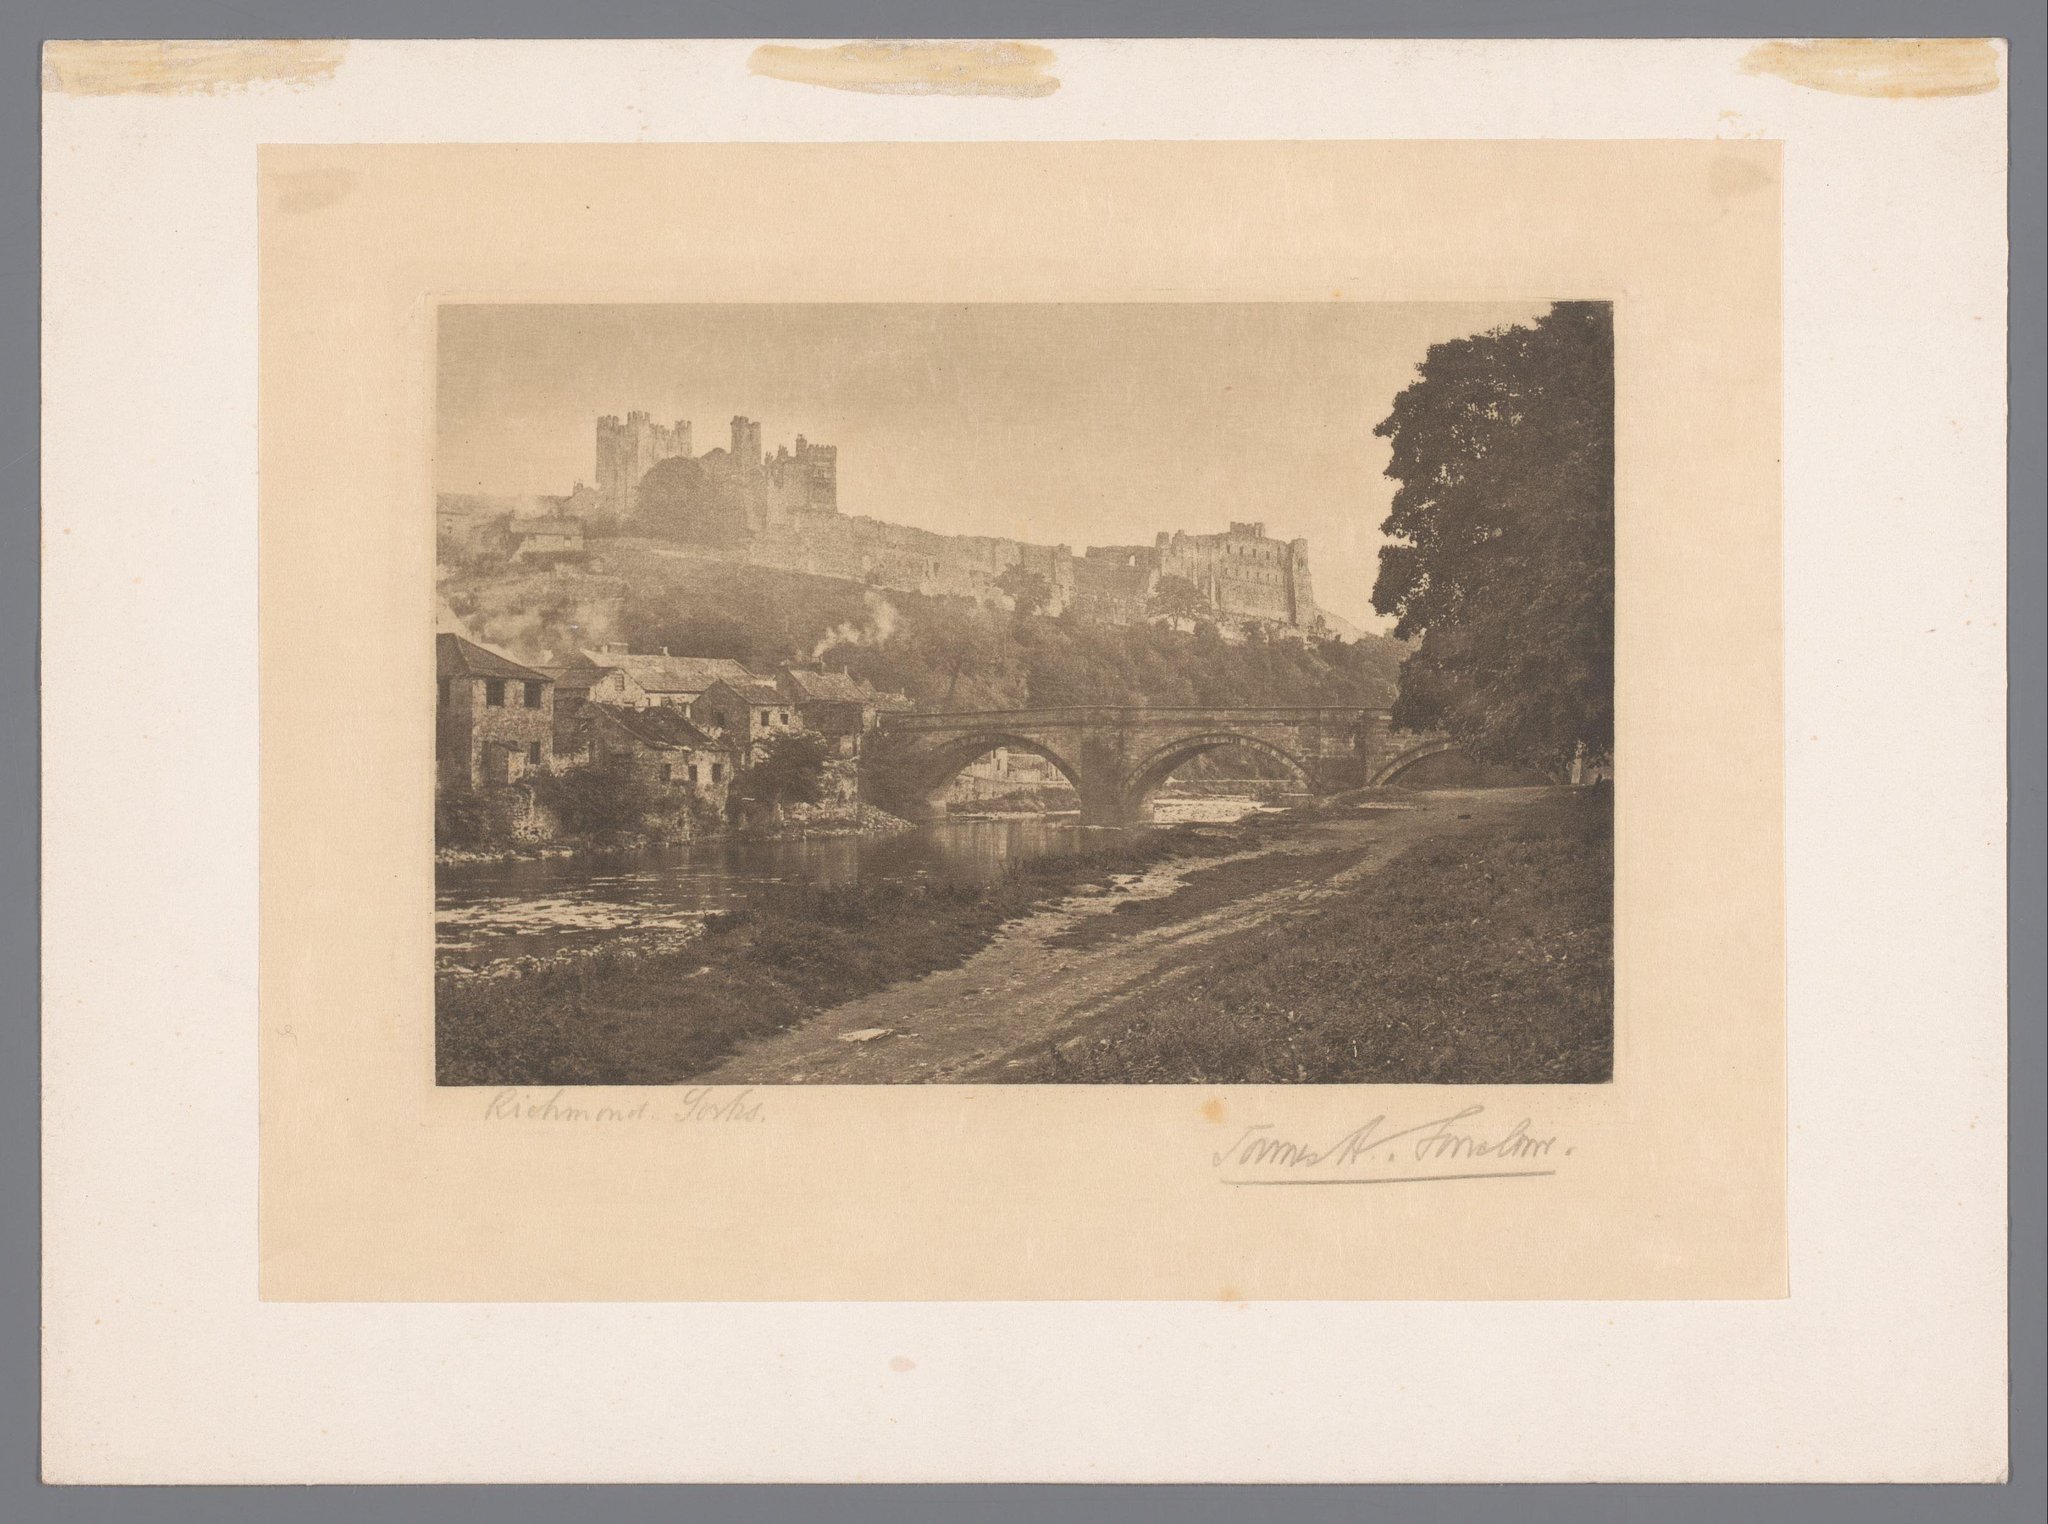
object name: photograph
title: Gezicht op kasteel en stad Richmond aan de rivier Swale, North Yorkshire, Engeland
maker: Anonymous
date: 1875-1890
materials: cardboard, paper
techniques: photoaquatint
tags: yorkshire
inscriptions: caption: ‘Richmond. Sorks [?].’, signature: ‘James A. Smal...[?]’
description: Gezicht op Richmond Castle en Richmond aan de rivier Swale, North Yorkshire, Engeland.